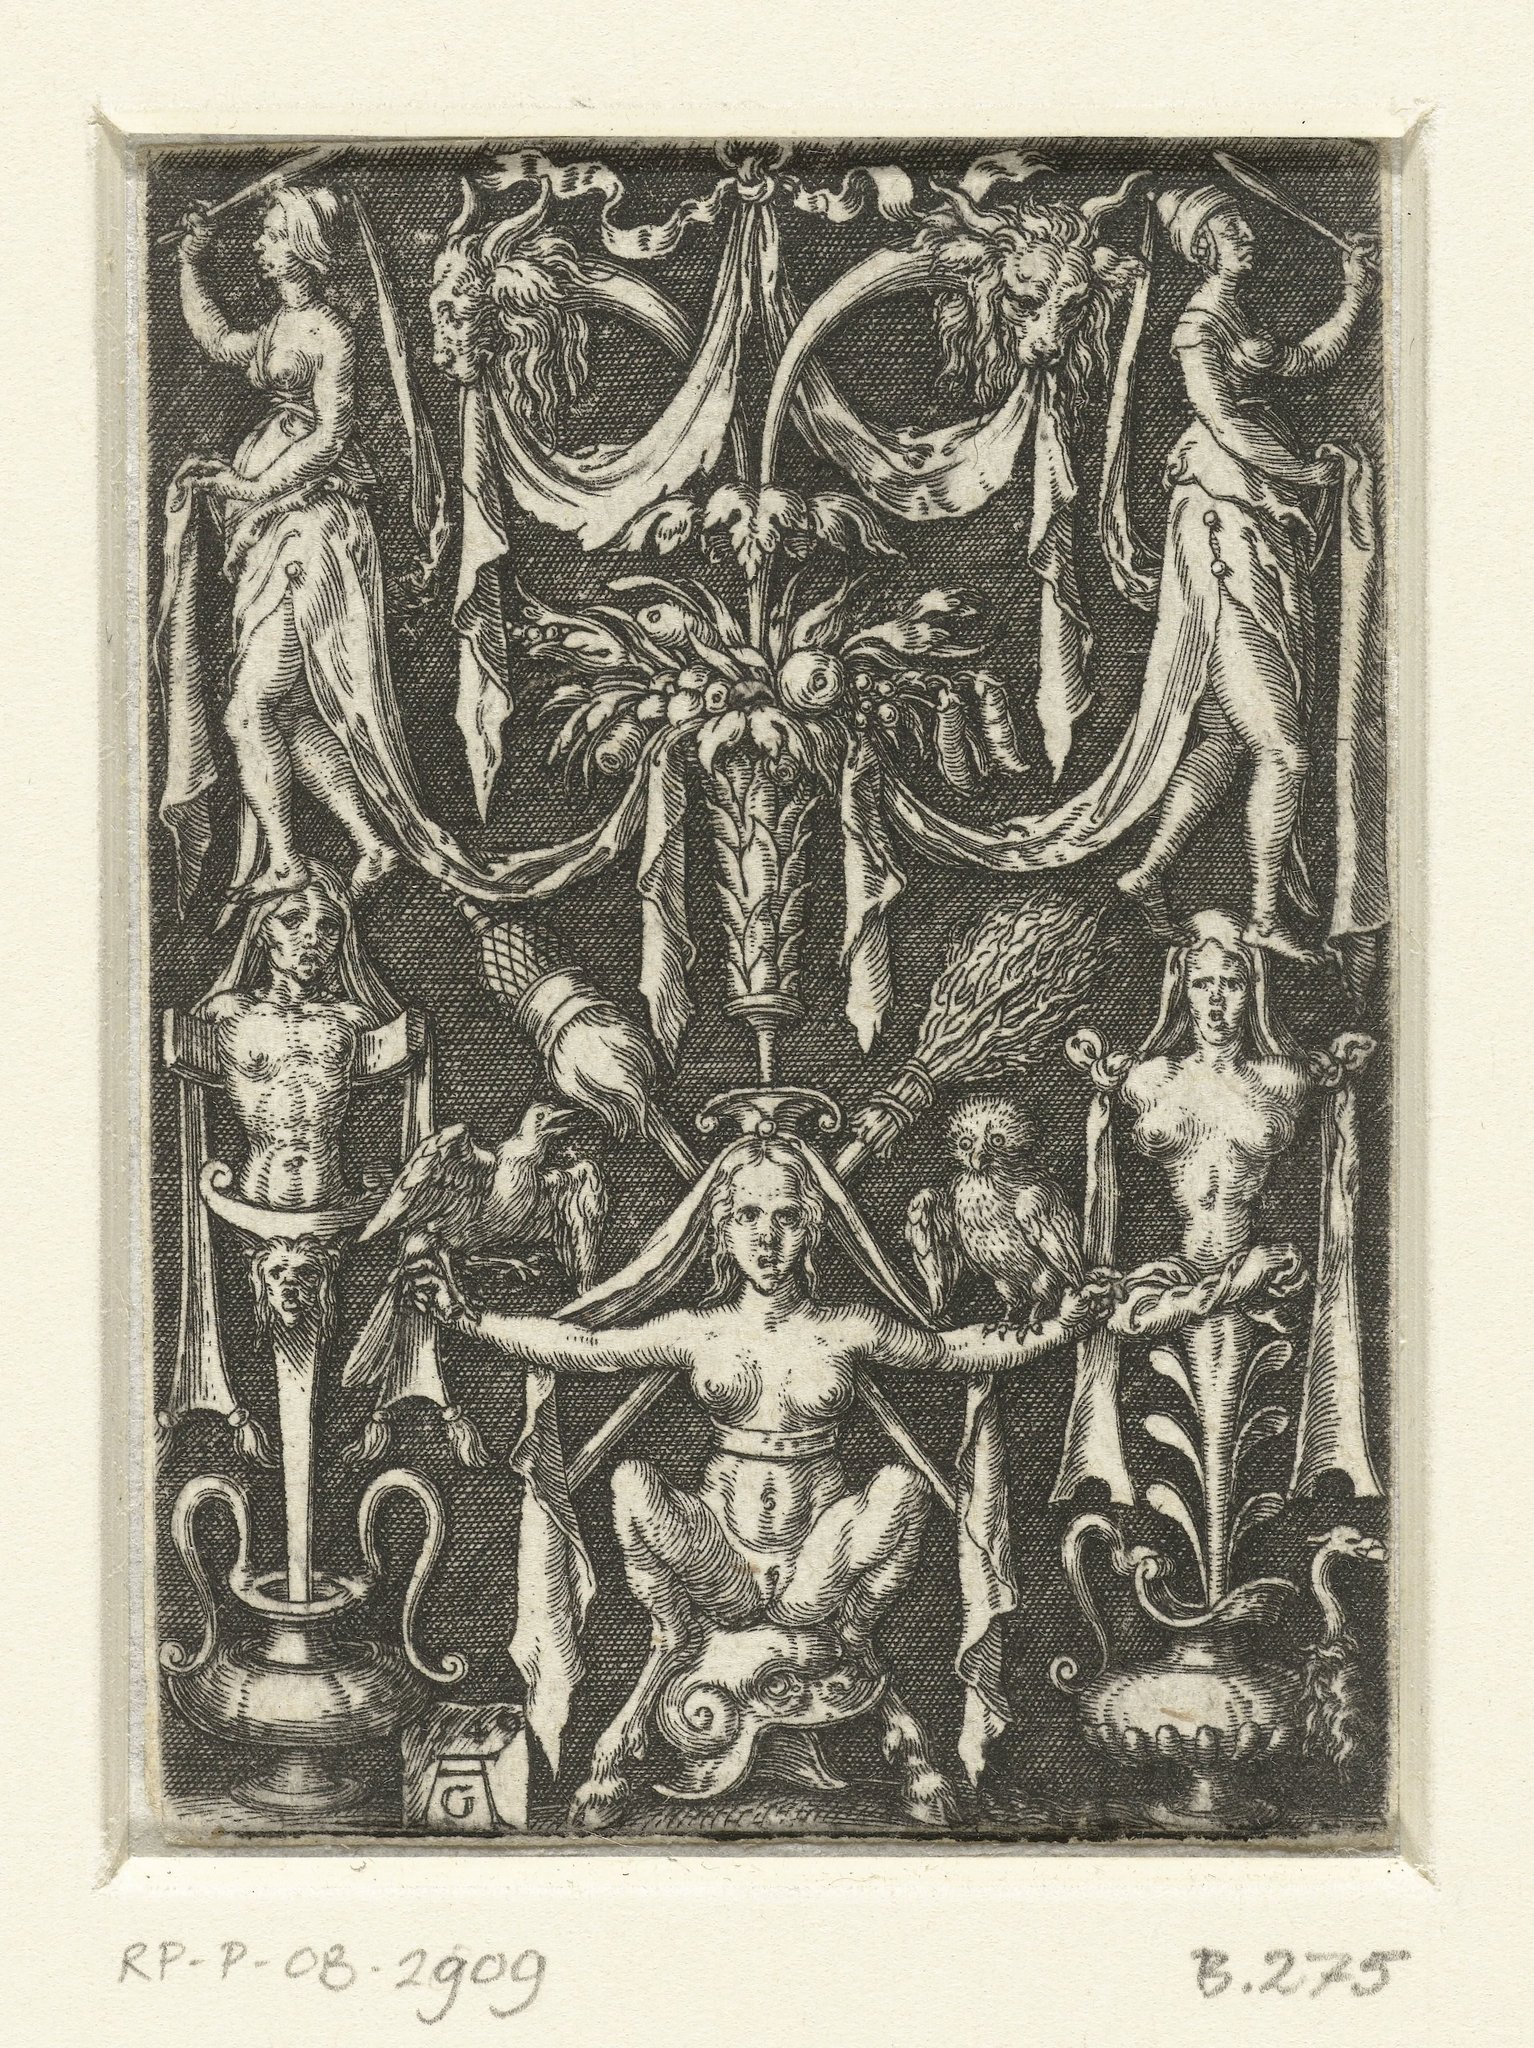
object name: ornament print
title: Vlakdecoratie met grotesken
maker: heinrich aldegrever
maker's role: draughtsman, print maker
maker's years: 1502-1561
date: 1549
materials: paper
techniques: engraving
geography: germany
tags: ornaments ~ art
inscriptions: number: ‘23’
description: Vlakdecoratie met midden onder een gehurkte vrouwelijke sater met een uil en een vogel op haar arm. Aan weerszijden twee hermen die in vazen staan. Achter de rug van de sater staan gekruist een spinrokken en een bezem. De hermen dragen elk op hun hoofd een vrouw met een spinrokken.